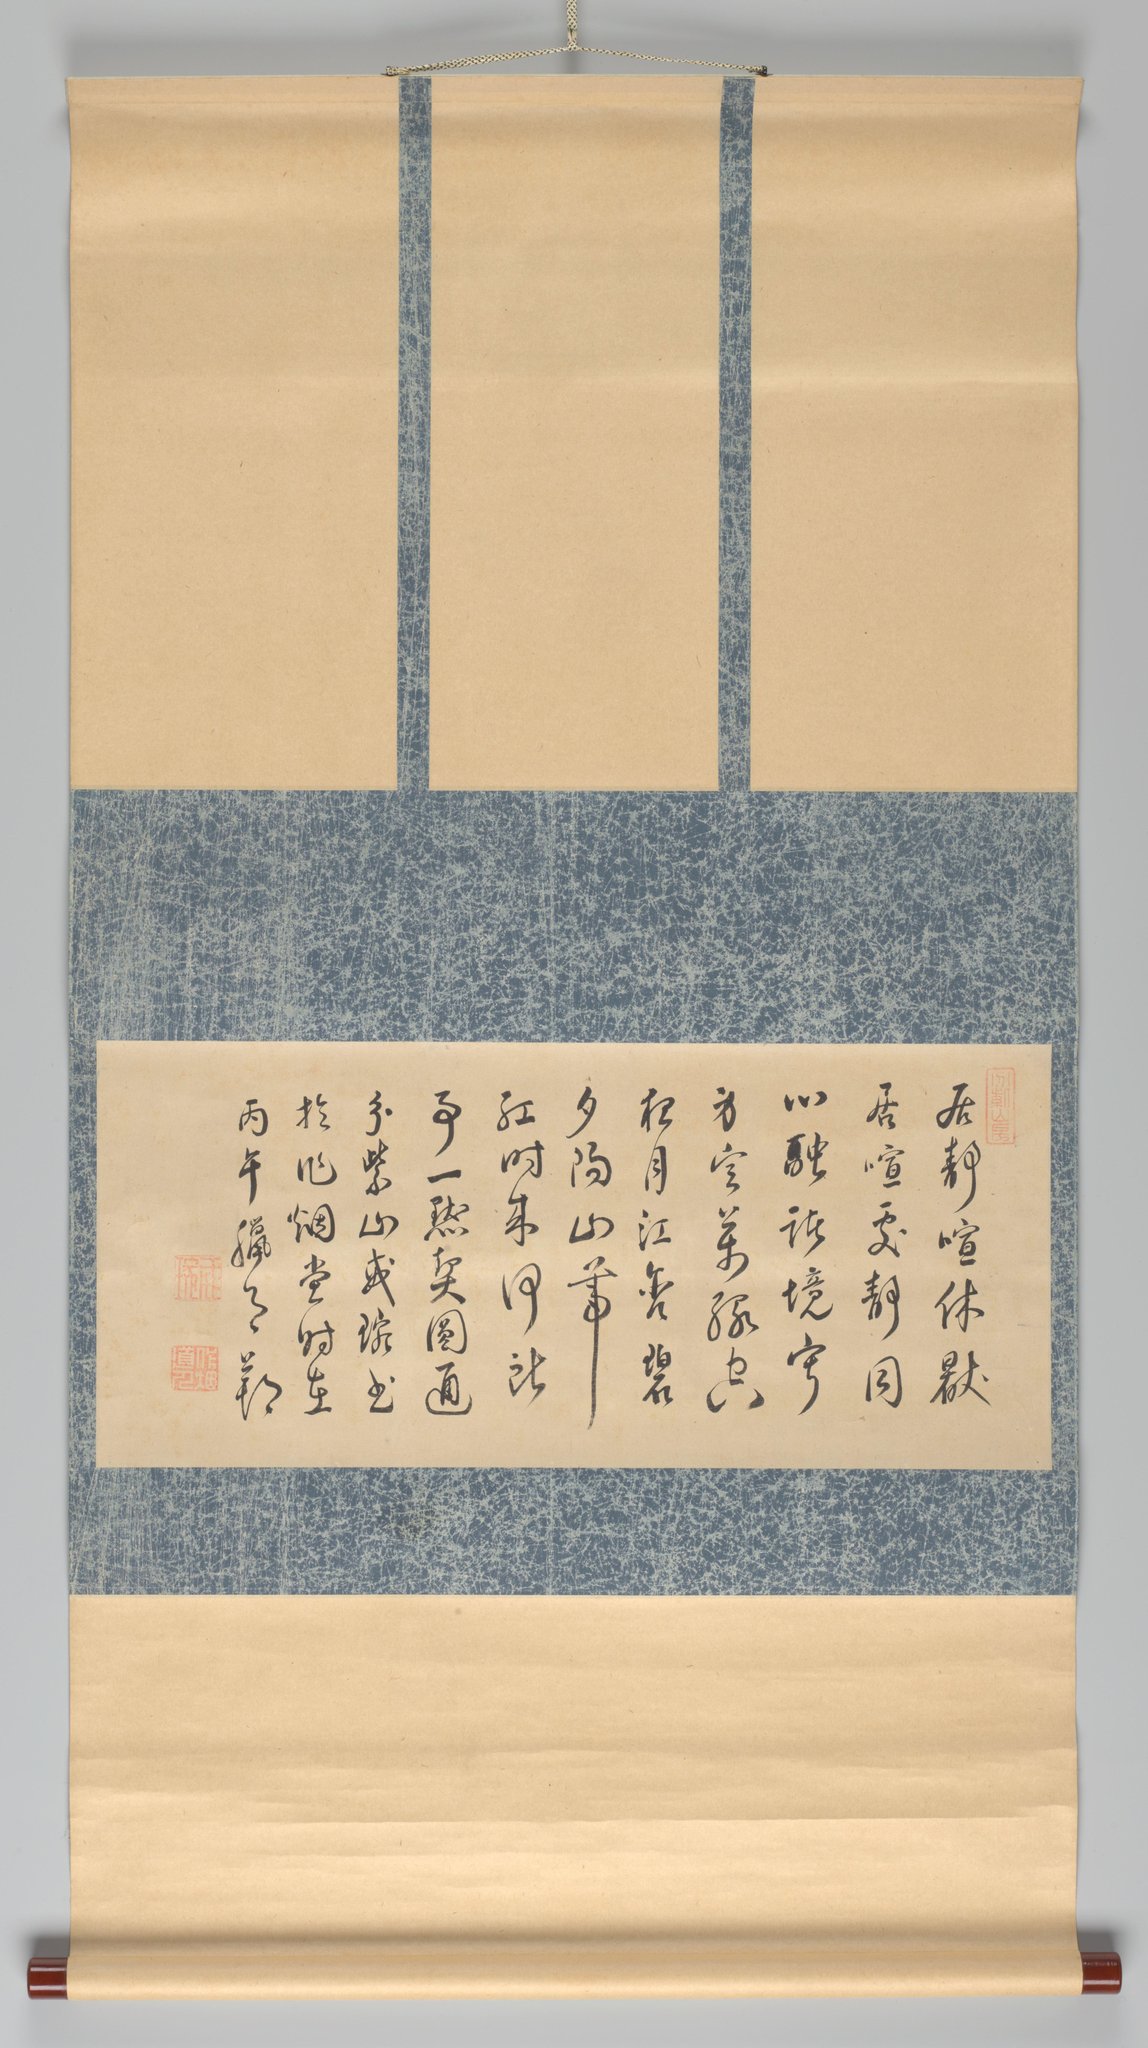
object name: hanging scroll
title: Zen-kalligrafie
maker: unken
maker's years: 1610-1673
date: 1610-1673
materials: ink, paper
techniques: calligraphy